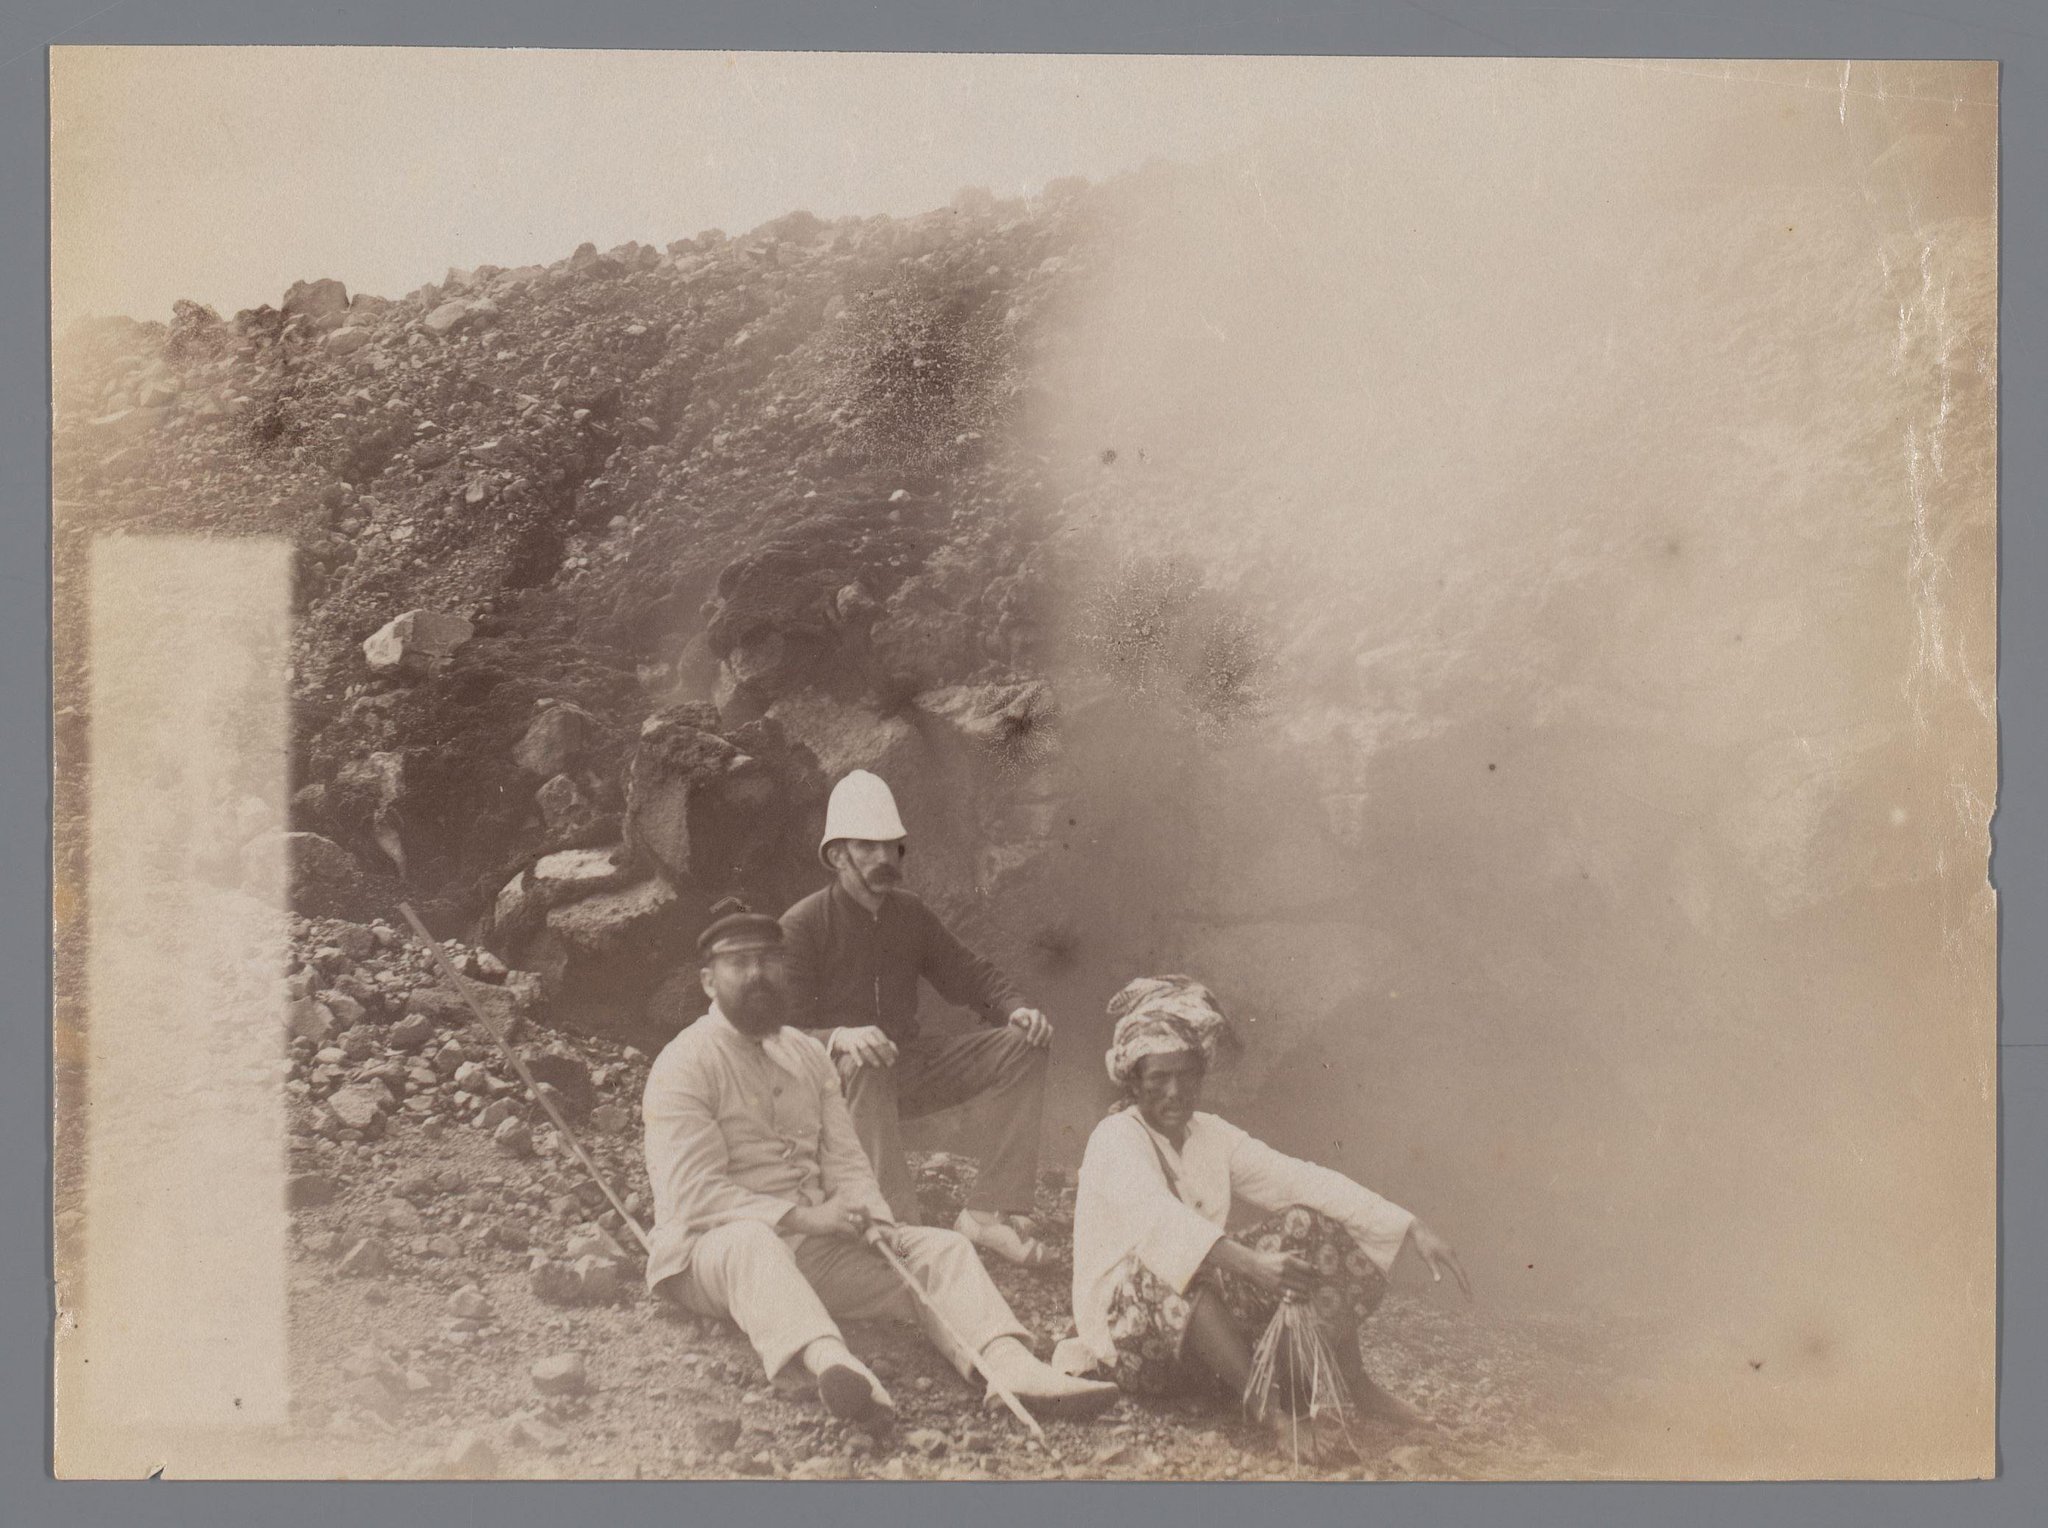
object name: photograph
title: Foto van drie mannen naast een krater tijdens een expeditie, Padang, West-Sumatra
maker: Anonymous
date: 1890-1920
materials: paper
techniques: albumen print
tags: sumatra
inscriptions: inscription: ‘Fumarol [?]//bij de krater van Muapi//Padangsche bovenlanden’, inscription: ‘[?]’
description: Foto van drie mannen naast een krater tijdens een expeditie, Padang, West-Sumatra.